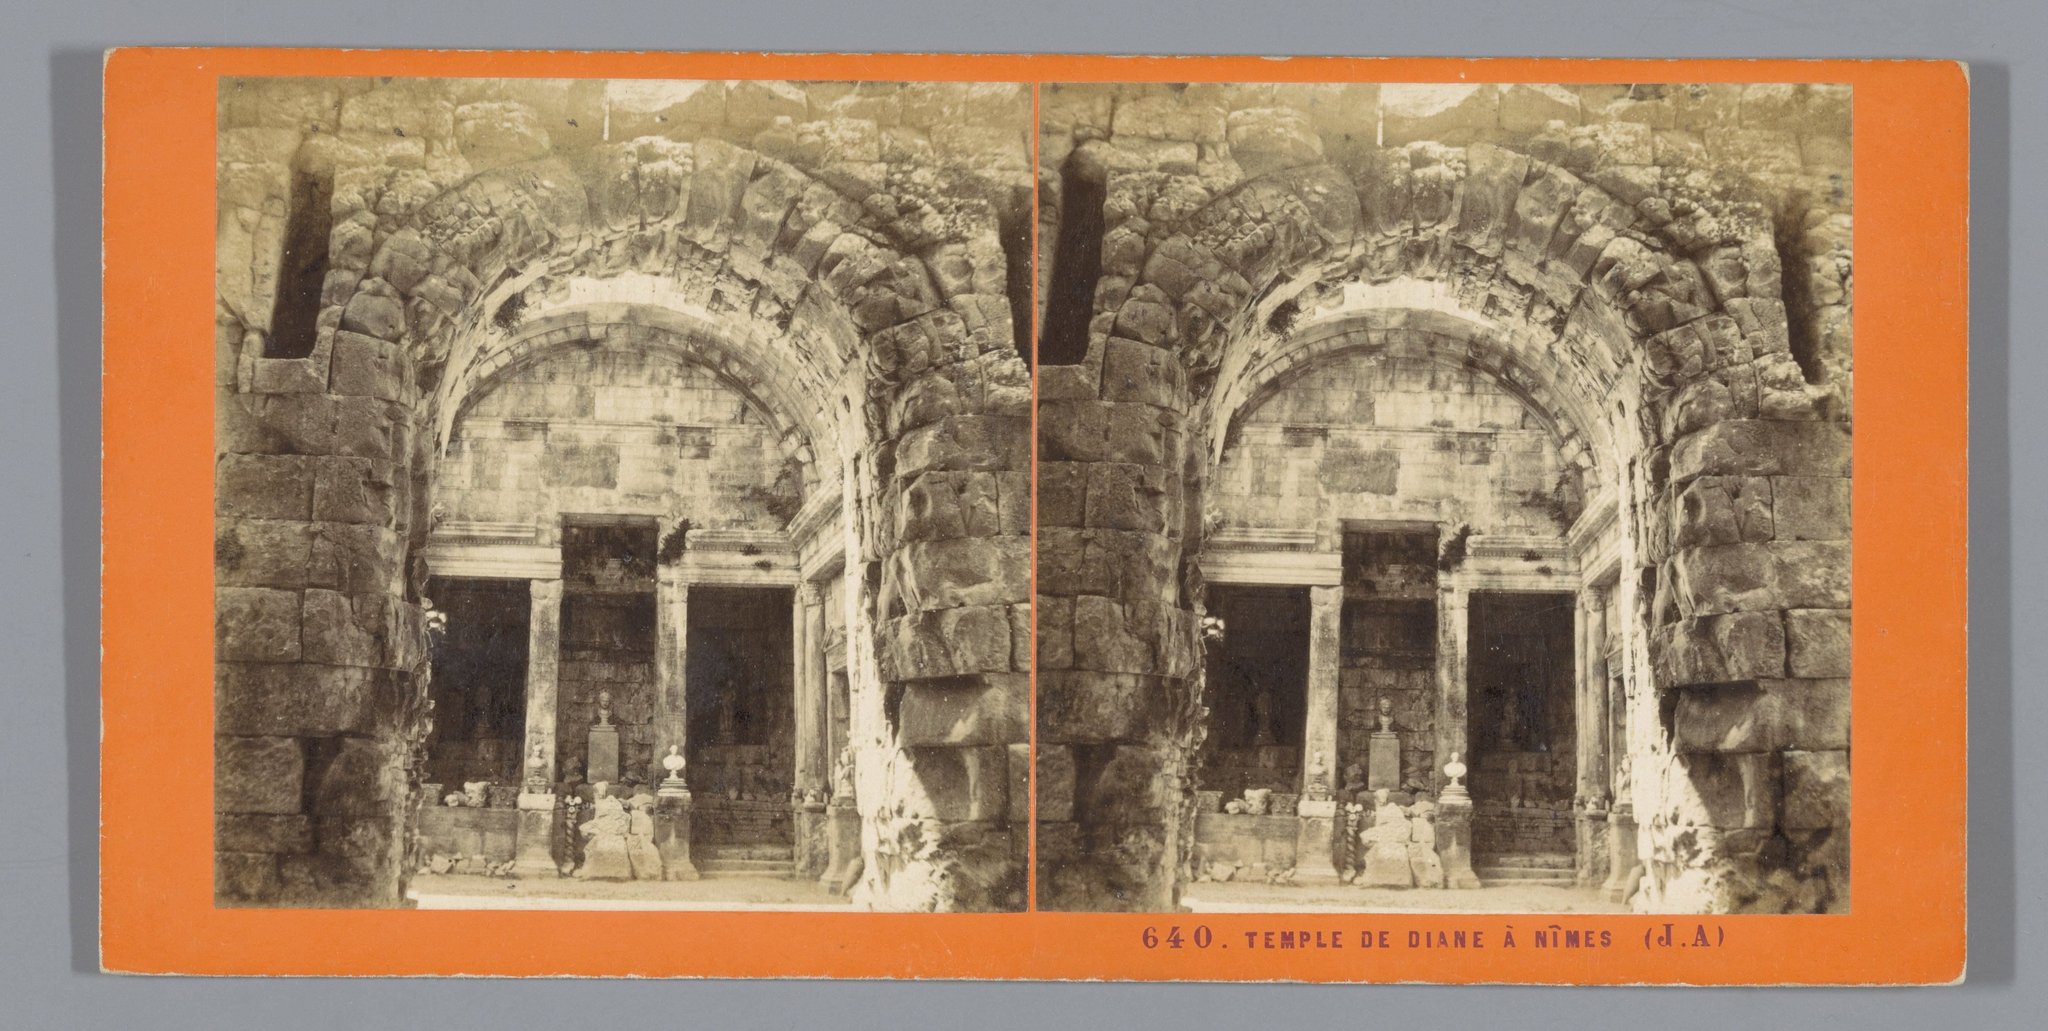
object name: stereograph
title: Gezicht op de Temple de Diane in Nîmes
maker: jean andrieu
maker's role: fotograaf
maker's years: 1816-1872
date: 1862-1876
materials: cardboard, photographic support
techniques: albumen print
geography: nîmes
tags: ruin of a building ~ architecture, temple, shrine ~ roman religion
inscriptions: number: ‘640.’